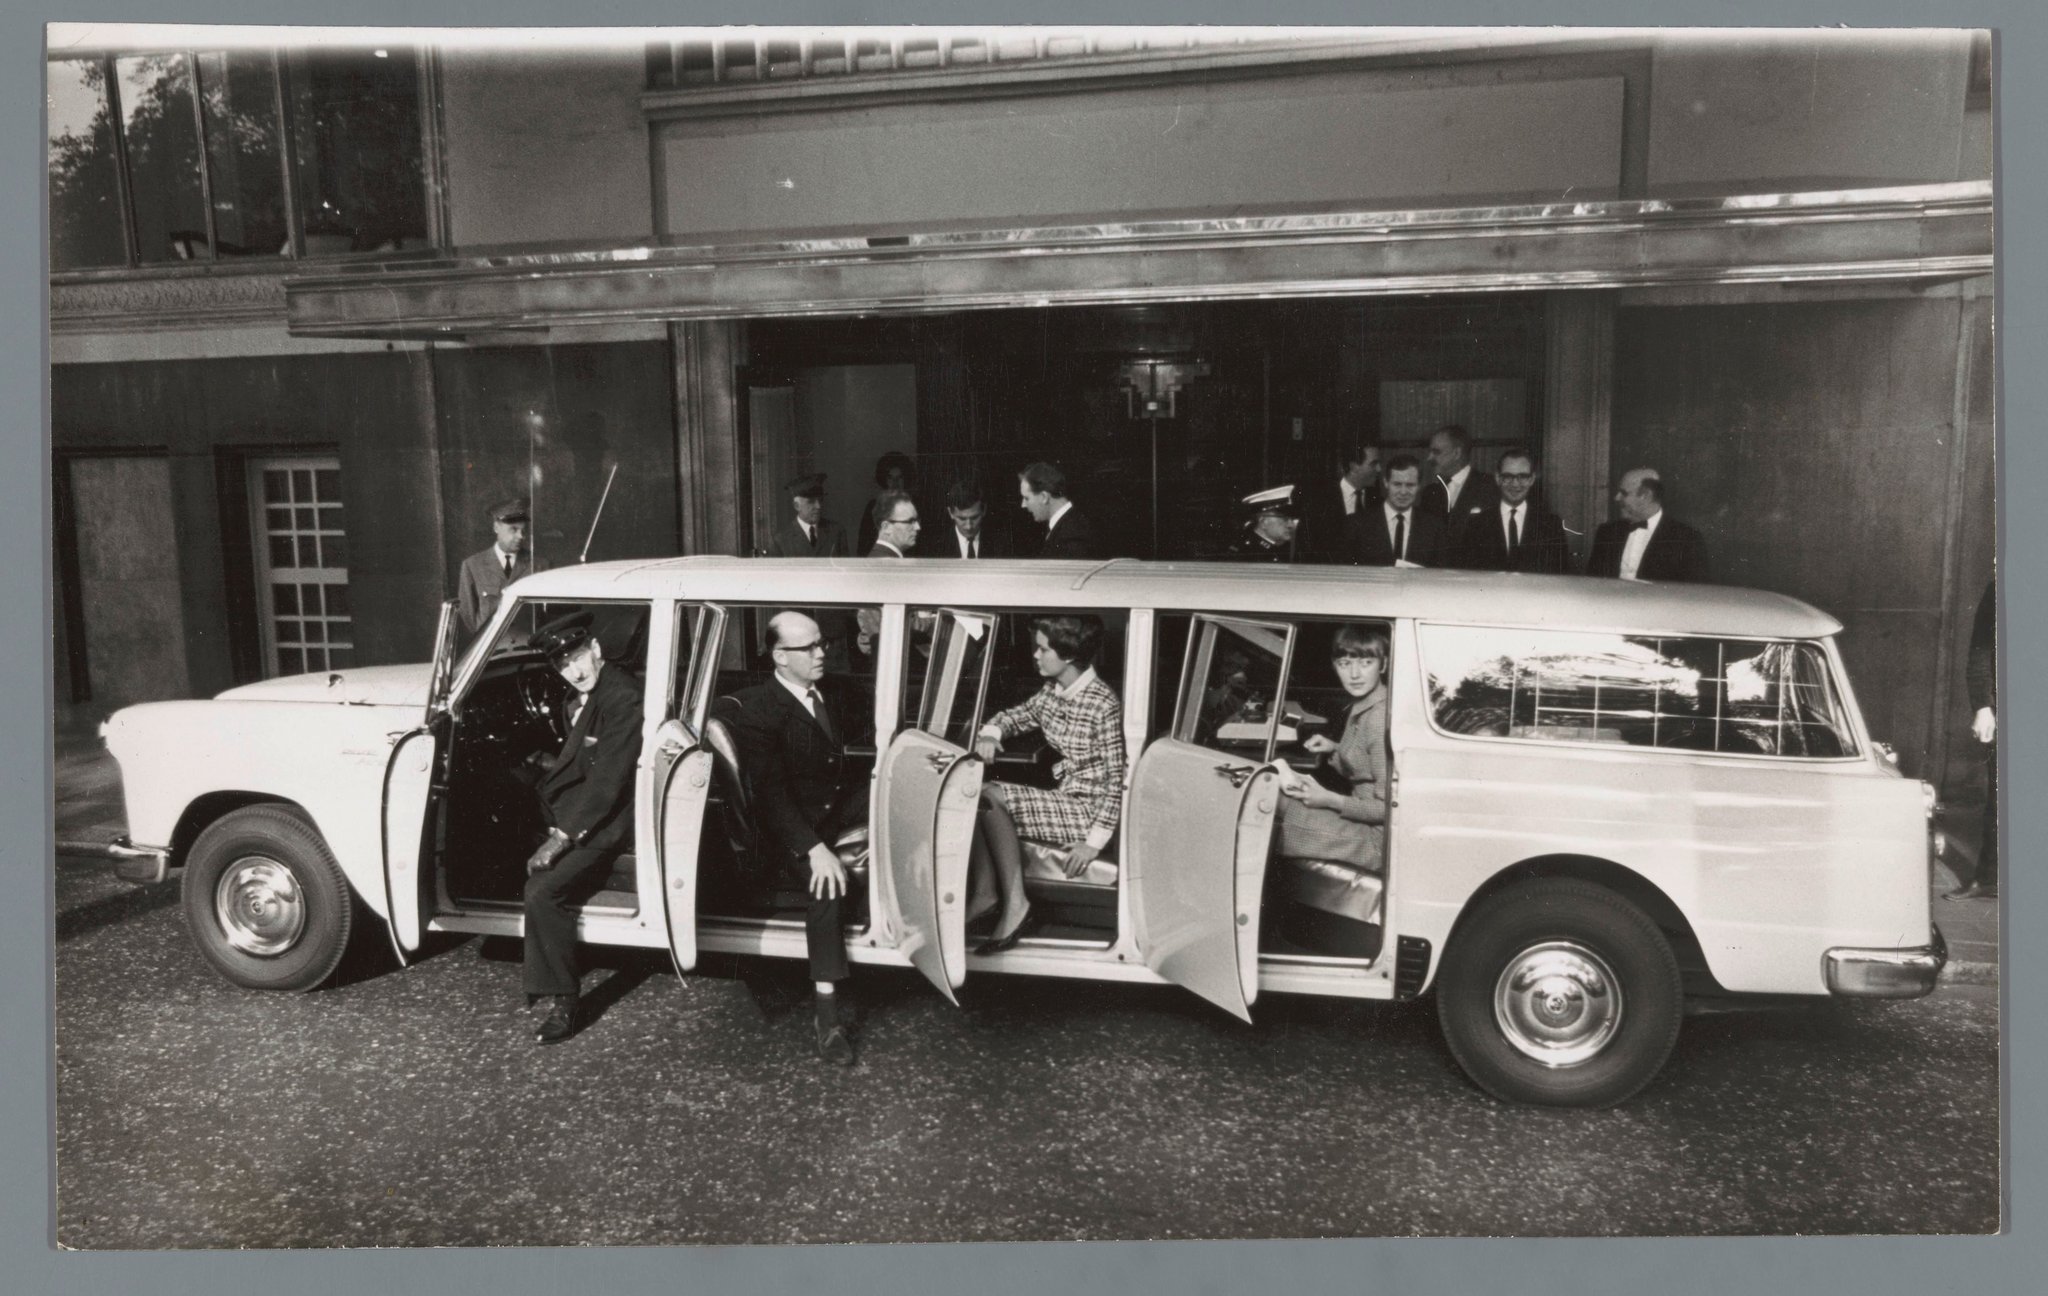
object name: photograph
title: Passagiers in een Checker Aerocar tijdens de British International Motor Show te Londen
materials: photographic support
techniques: gelatin silver print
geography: earls court exhibition centre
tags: automobile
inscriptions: inscription: ‘16-10-65 The worlds longest car (...) 1/784884’, inscription: ‘Keystone (...) London’